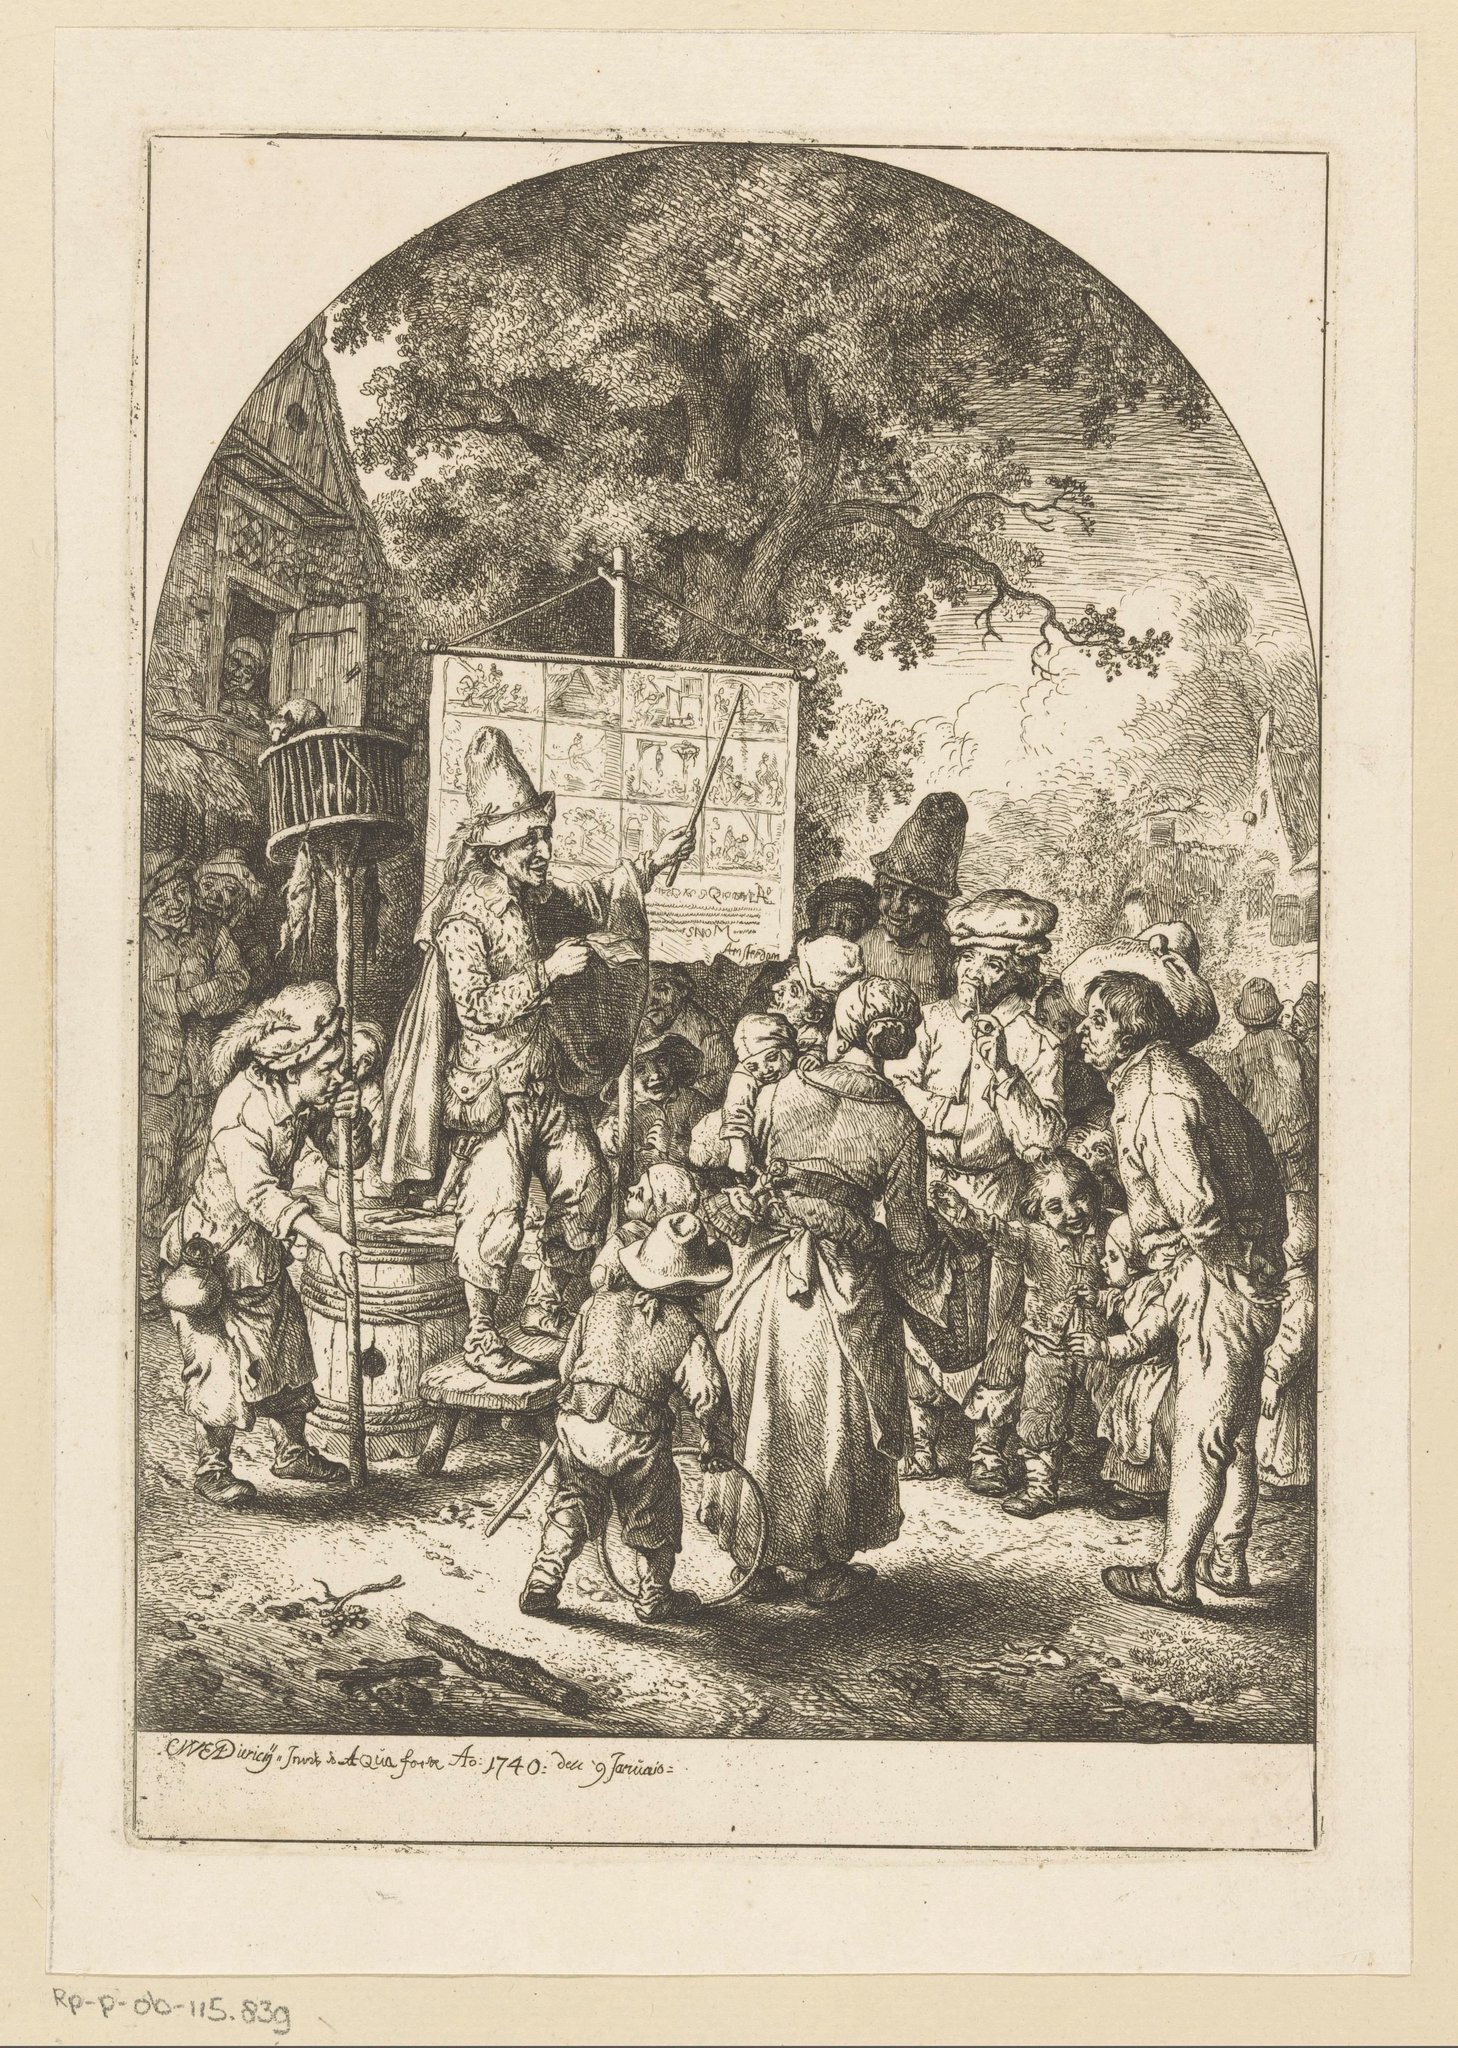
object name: print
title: Minstreel spreekt dorpelingen toe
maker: christian wilhelm ernst dietrich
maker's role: artist, painter, print maker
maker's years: 1712-1774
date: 1740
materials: paper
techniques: etching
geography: netherlands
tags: city-view, and landscape with man-made constructions, (bowling a) hoop (+ out of doors (sports, games, etc.)), minstrel, 'jongleur' - cc - out of doors, rat exterminator, education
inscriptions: date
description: De minstreel wijst naar een oprolbare plaat met afbeeldingen van onder andere een galg. Onderaan deze plaat staat de stad Amsterdam vermeld.